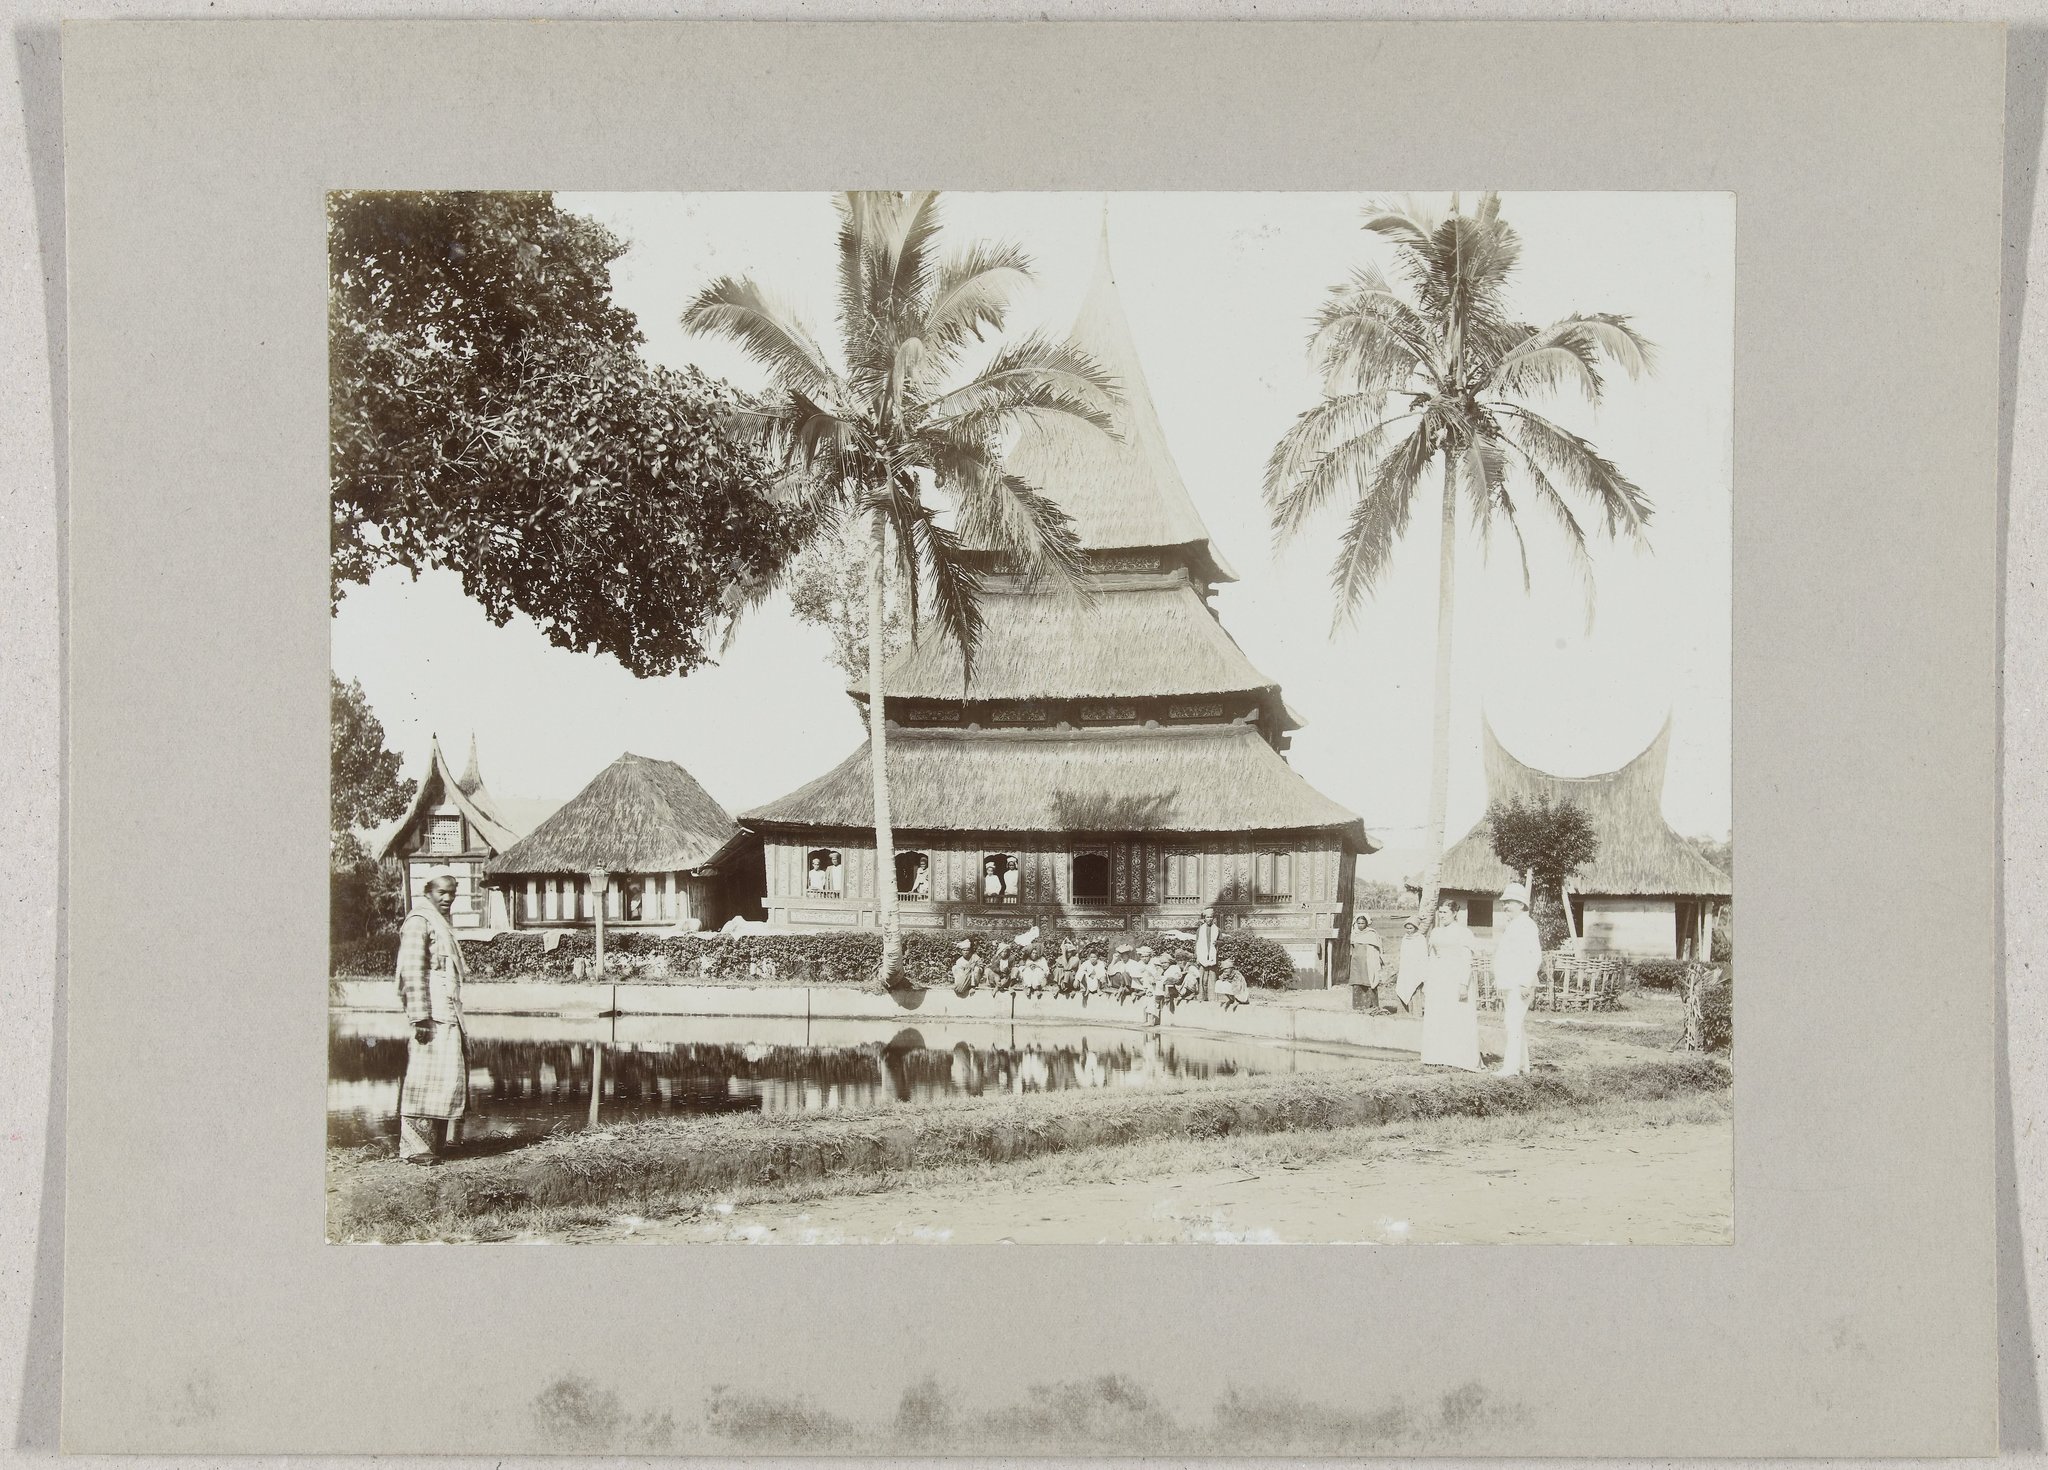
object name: photograph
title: 6. Vischvijver Fort de Kock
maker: Anonymous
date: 1895-1915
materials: cardboard, paper, photographic support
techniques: gelatin silver print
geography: sumatra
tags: indonesia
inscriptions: annotation: ‘6. Vischvijver Fort de Kock’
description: Moskee met visvijver te Kampong Taloek bij Fort de Kock, Sumatra, Nederlands-Indië. Rechts een Westers echtpaar, kinderen bij de rand van de vijver.